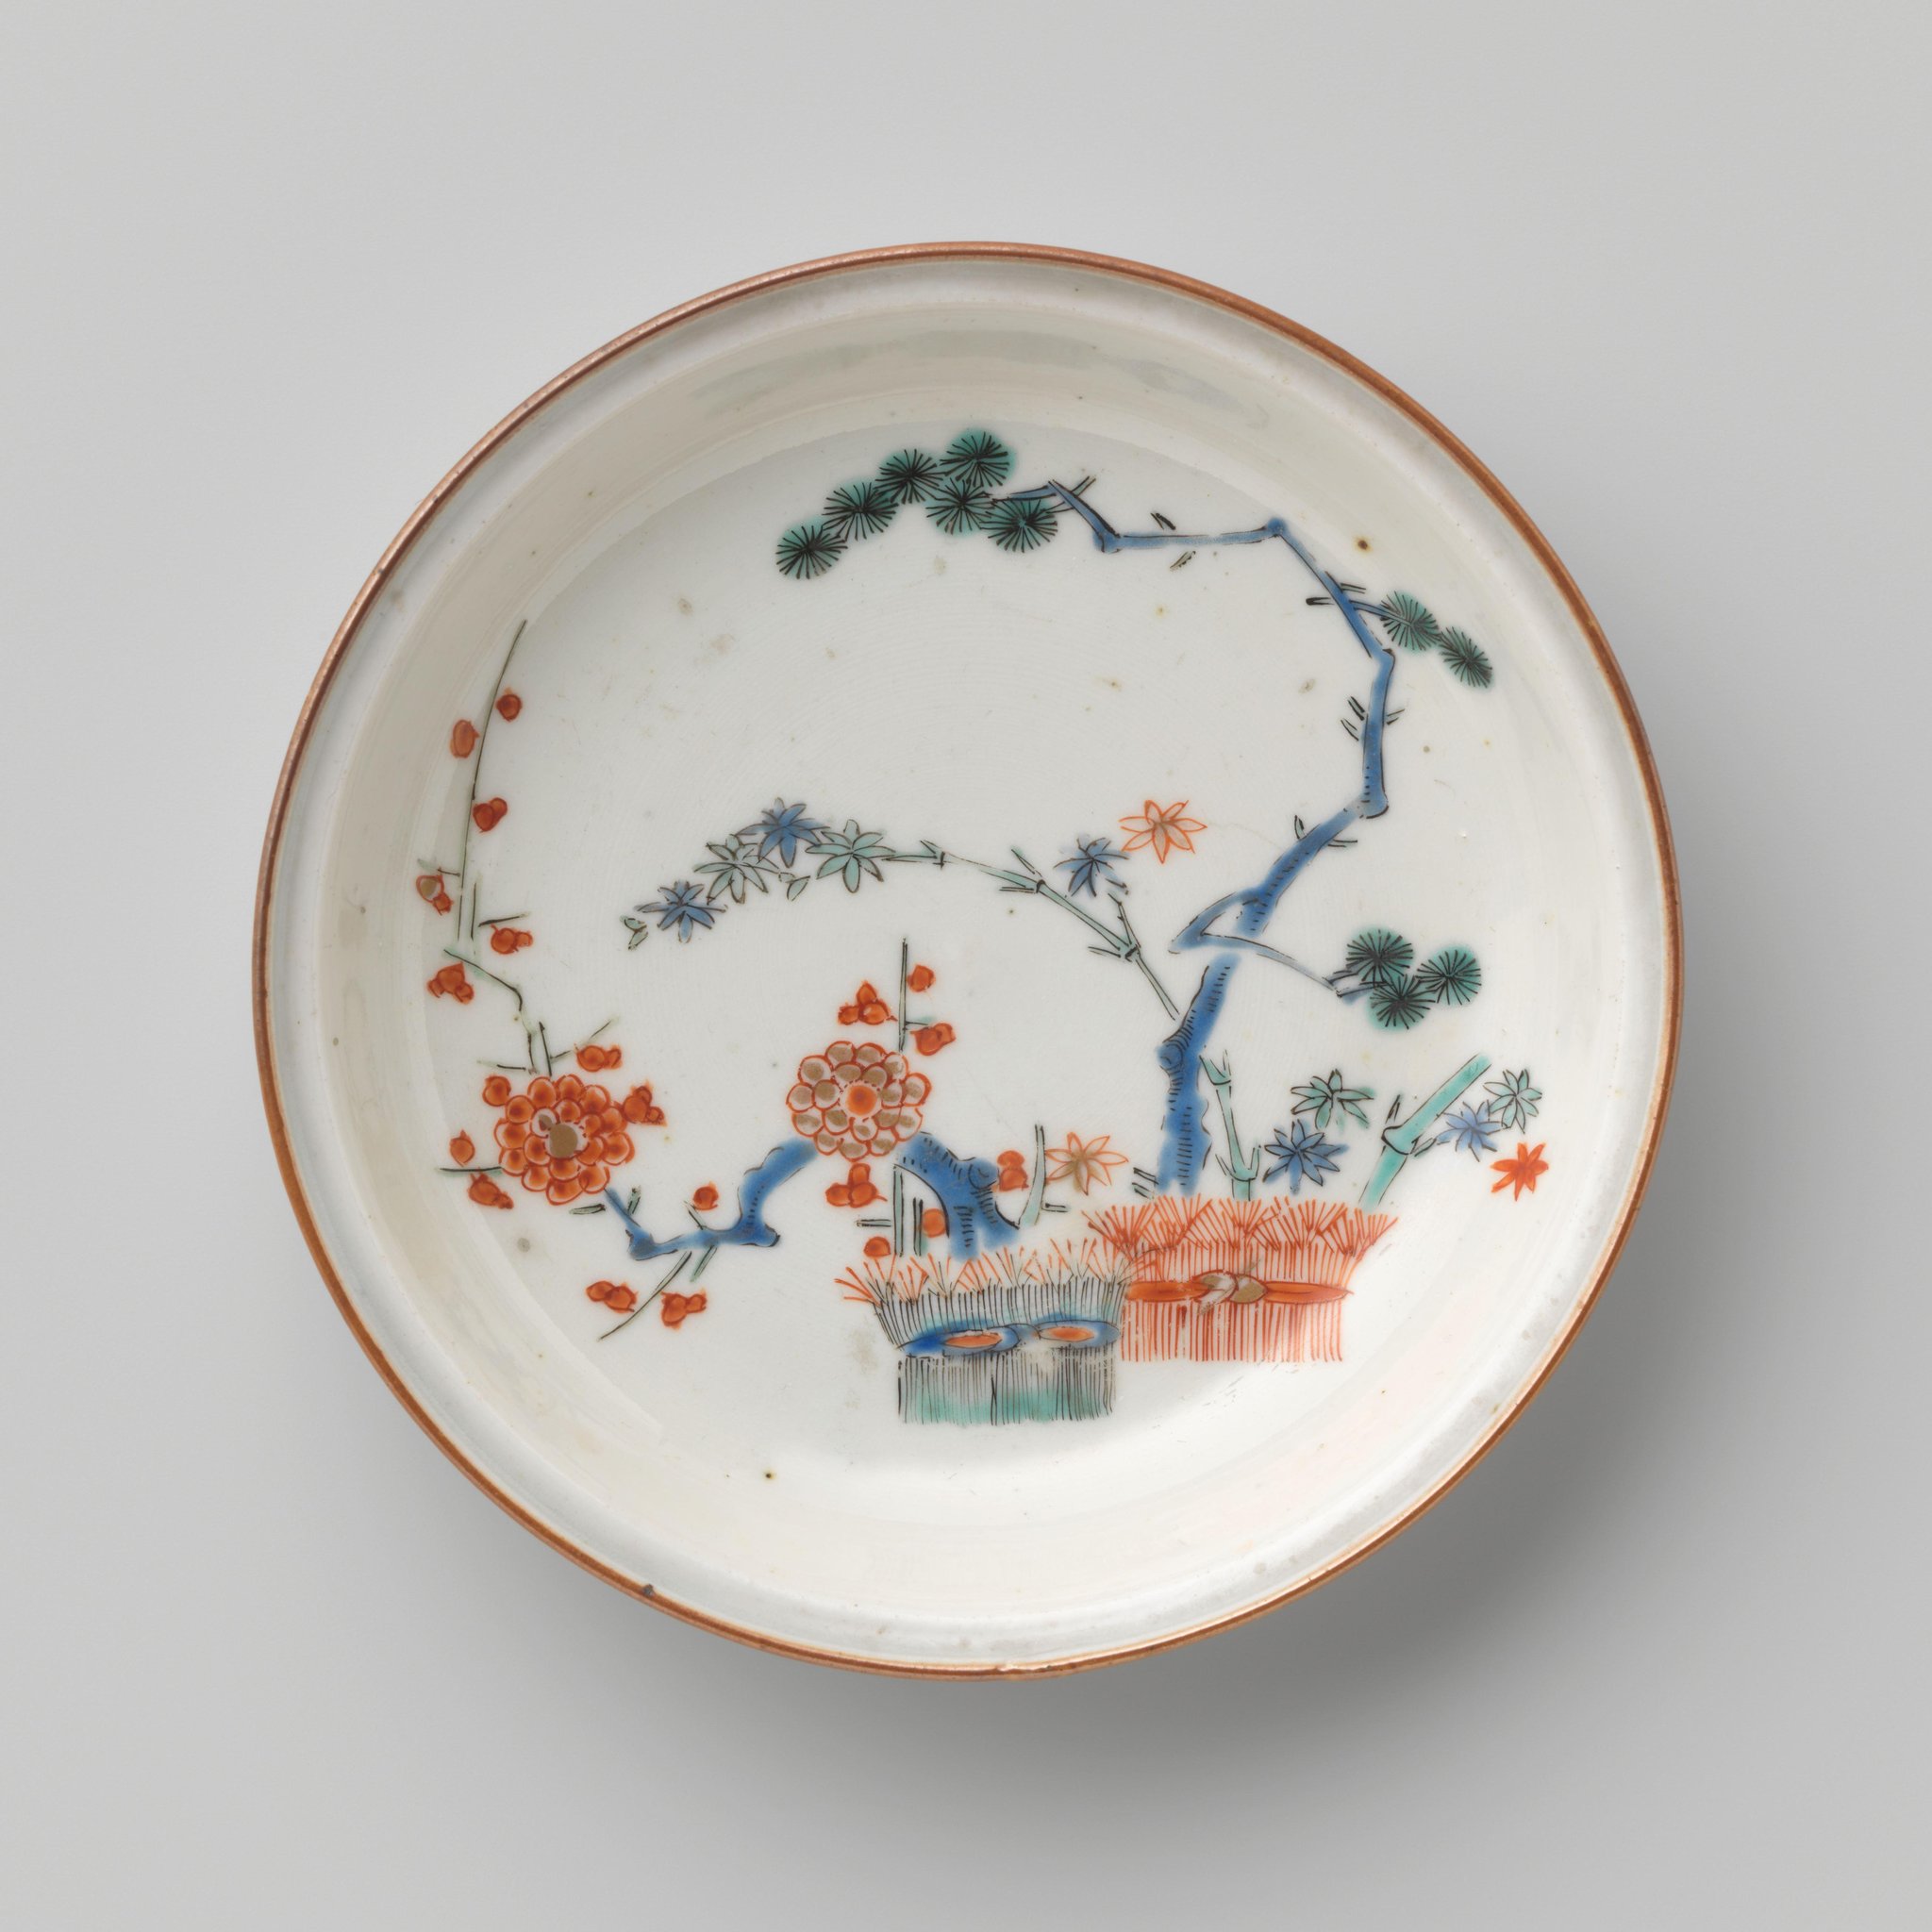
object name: platter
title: Saucer with the 'three friends of winter'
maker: Anonymous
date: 1670-1700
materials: glaze, gold, paint, porcelain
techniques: firing, gilding, turning, vitrification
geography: arita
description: Schotel van porselein, beschilderd op het glazuur in blauw, rood, groen, zwart en goud met de 'drie vrienden van de winter' (bamboe, prunus, pijnboom), bij twee gebonden heggen. Bruine rand. Kakiemon-stijl.